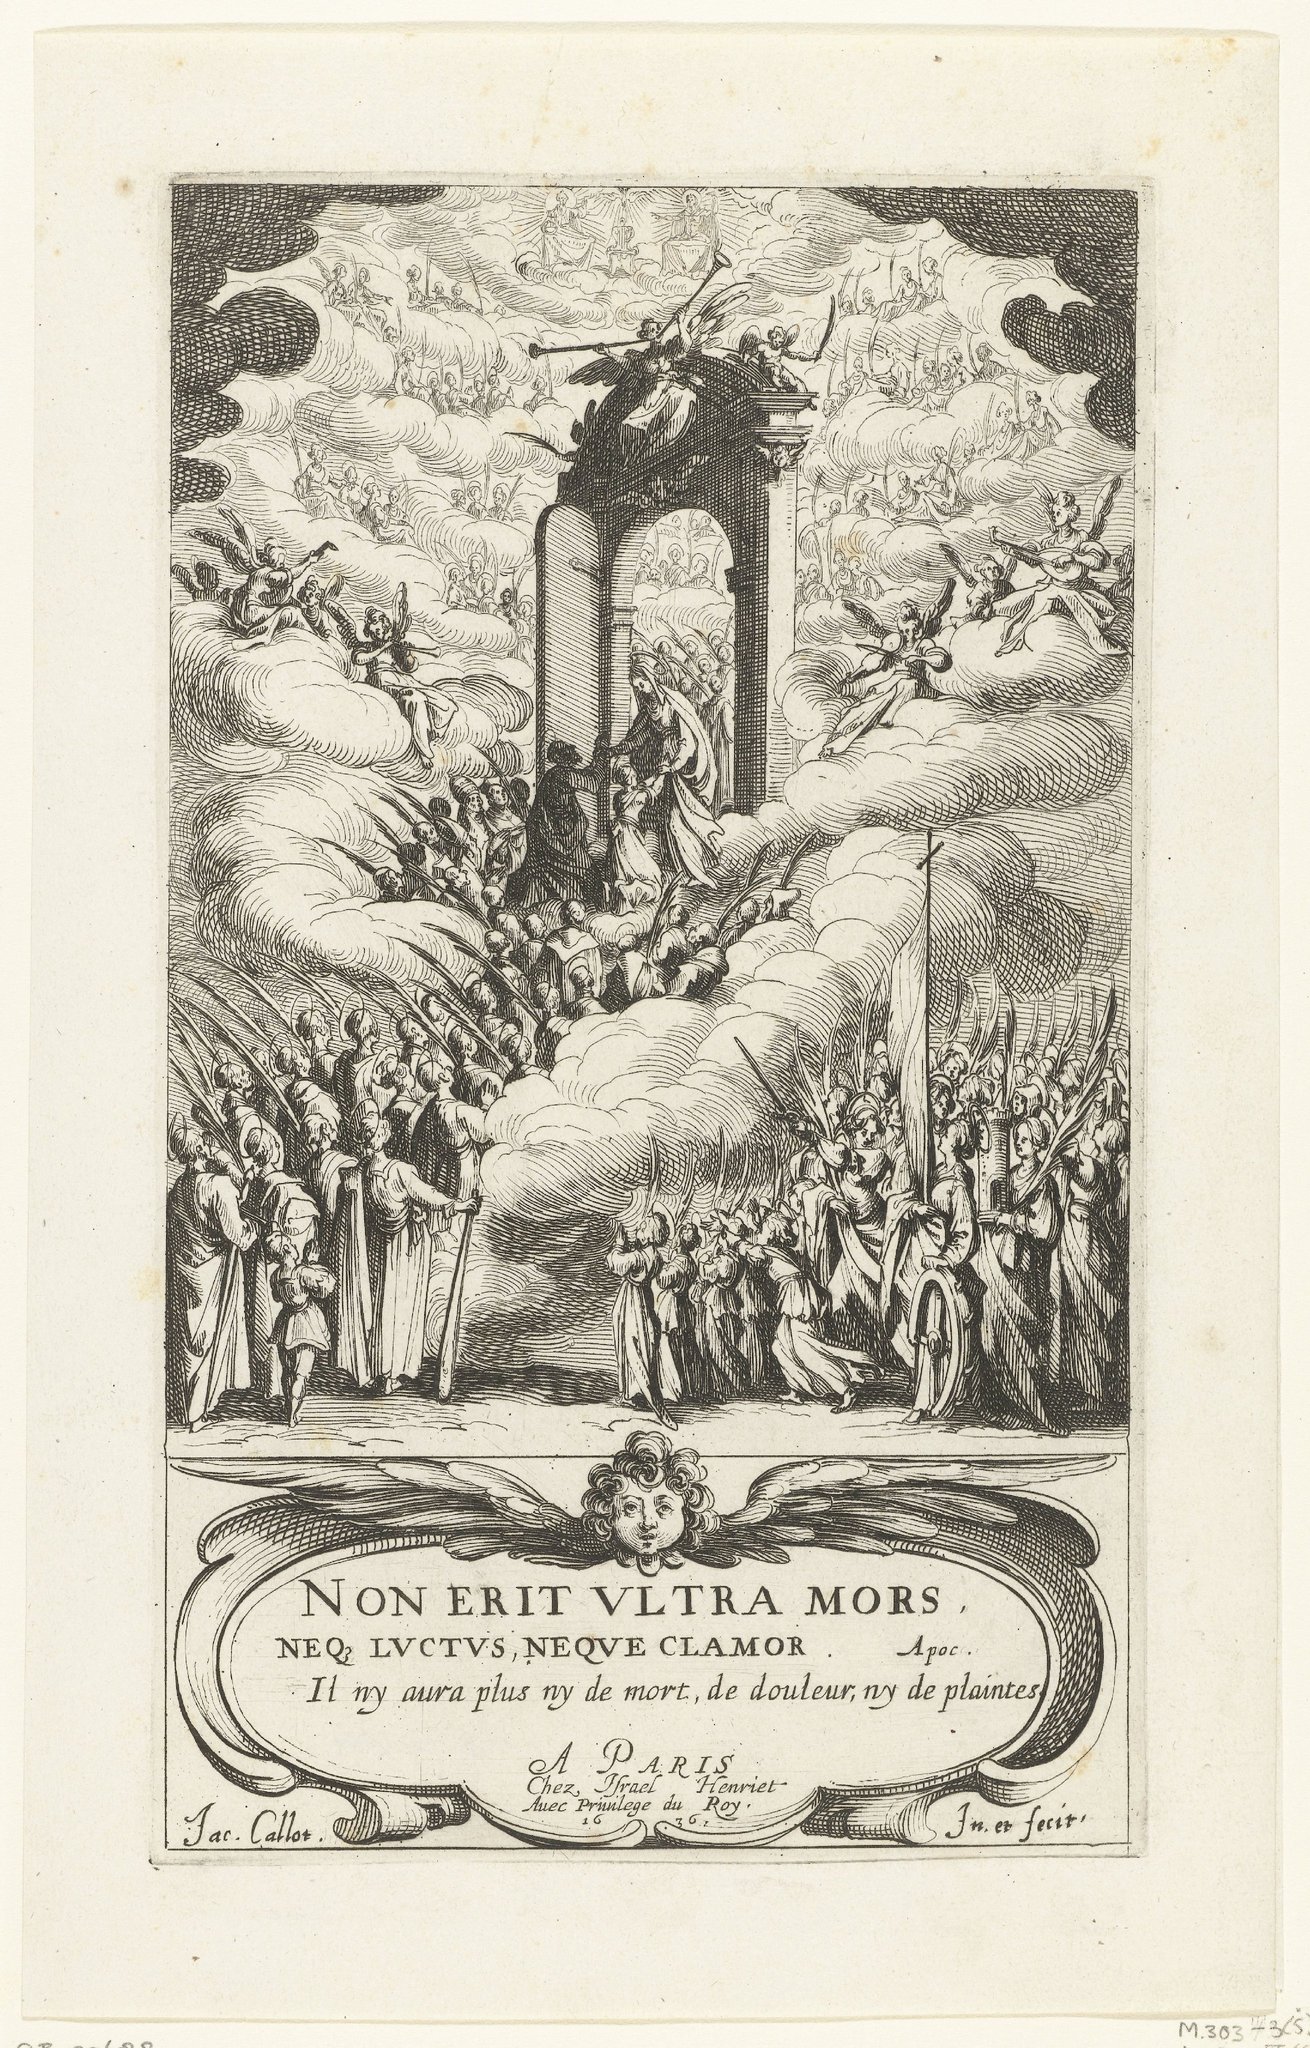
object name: print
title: Alle heiligen en de Christelijke feestdagen van het jaar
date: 1632-1636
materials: paper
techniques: etching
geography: paris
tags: the virgin martyr barbara; possible attributes: book, cannon(ball), crown, cross, chalice with wafer, dioscuros (her father), peacock feather, sword, torches, mason's tools, tower, the virgin martyr catherine of alexandria; possible attributes: book, crown, emperor maxentius, palm-branch, ring, sword, wheel, mary (without the christ-child), saints, the gate of heaven, entrance to heaven, 'porta coeli'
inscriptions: collector's mark: Lugt 240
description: Maria ontvangt bij de hemelpoort een stoet heiligen (onder wie Barbara en Catharina). Achter haar bevinden zich er al velen in de hemelse zaligheid. Onder deze voorstelling een Latijnse spreuk in cartouche. Deze prent is het frontispice voor een serie prenten met voorstellingen van de heiligen en de christelijke feestdagen van het jaar. Er zijn steeds vier scènes van één plaat op één blad gedrukt. Inclusief bijbehorend titelblad en frontispice gaat het in totaal om 124 platen (490 voorstellingen). De drie platen met de laatste 12 scènes (de veranderlijke christelijke feestdagen) zijn in de derde staat versneden tot 12 kleine plaatjes, en met een apart titelblad uitgegeven.